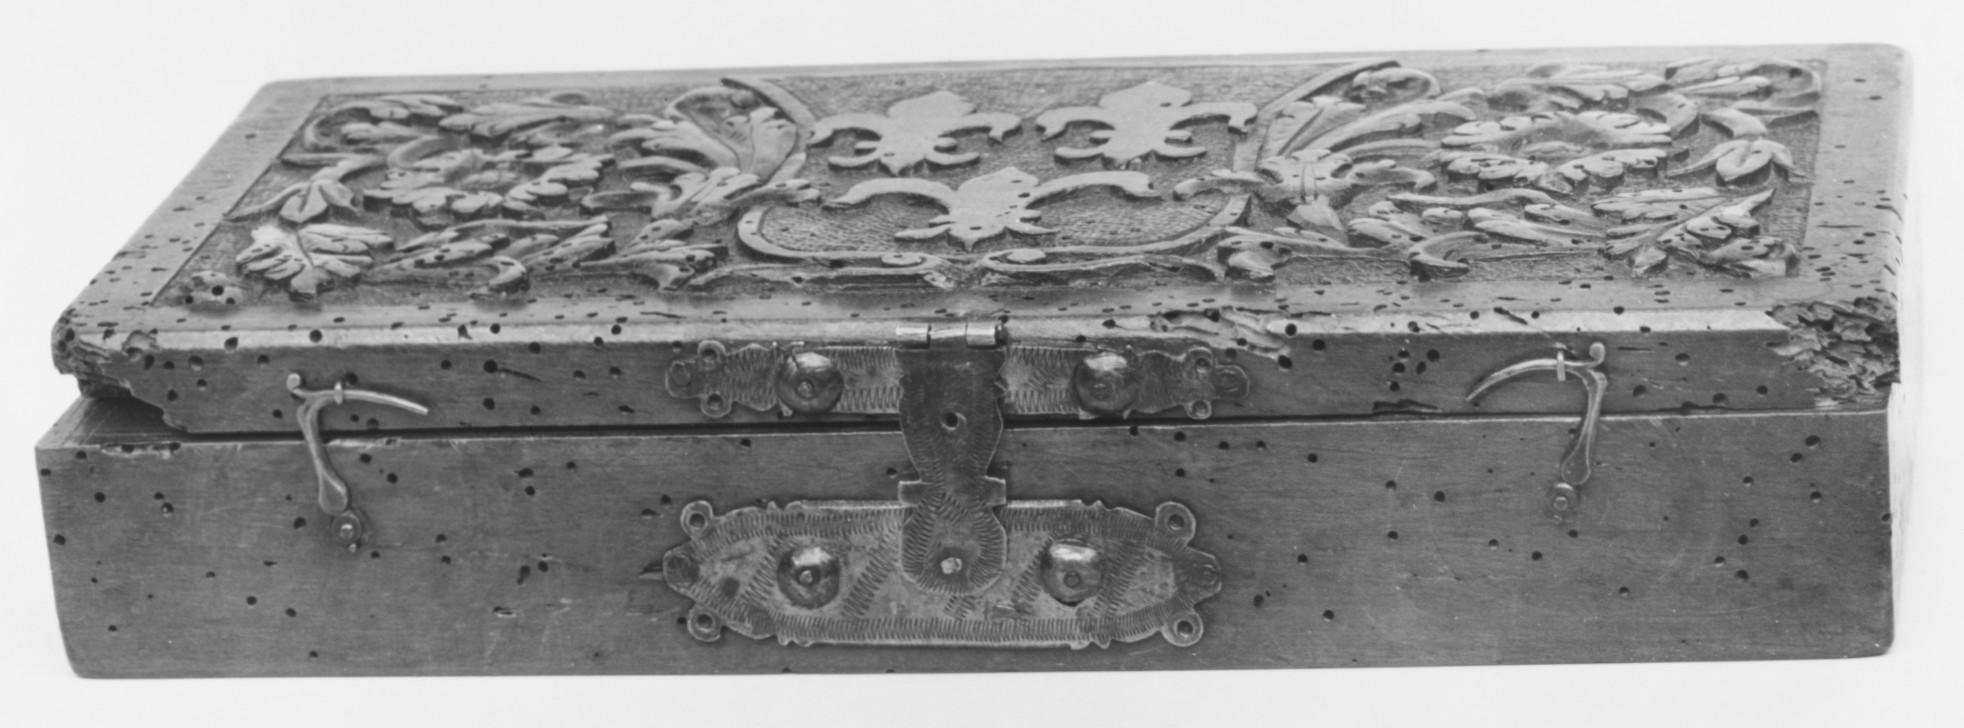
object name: money changer's box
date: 1667-1733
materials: brass, wood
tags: flowers